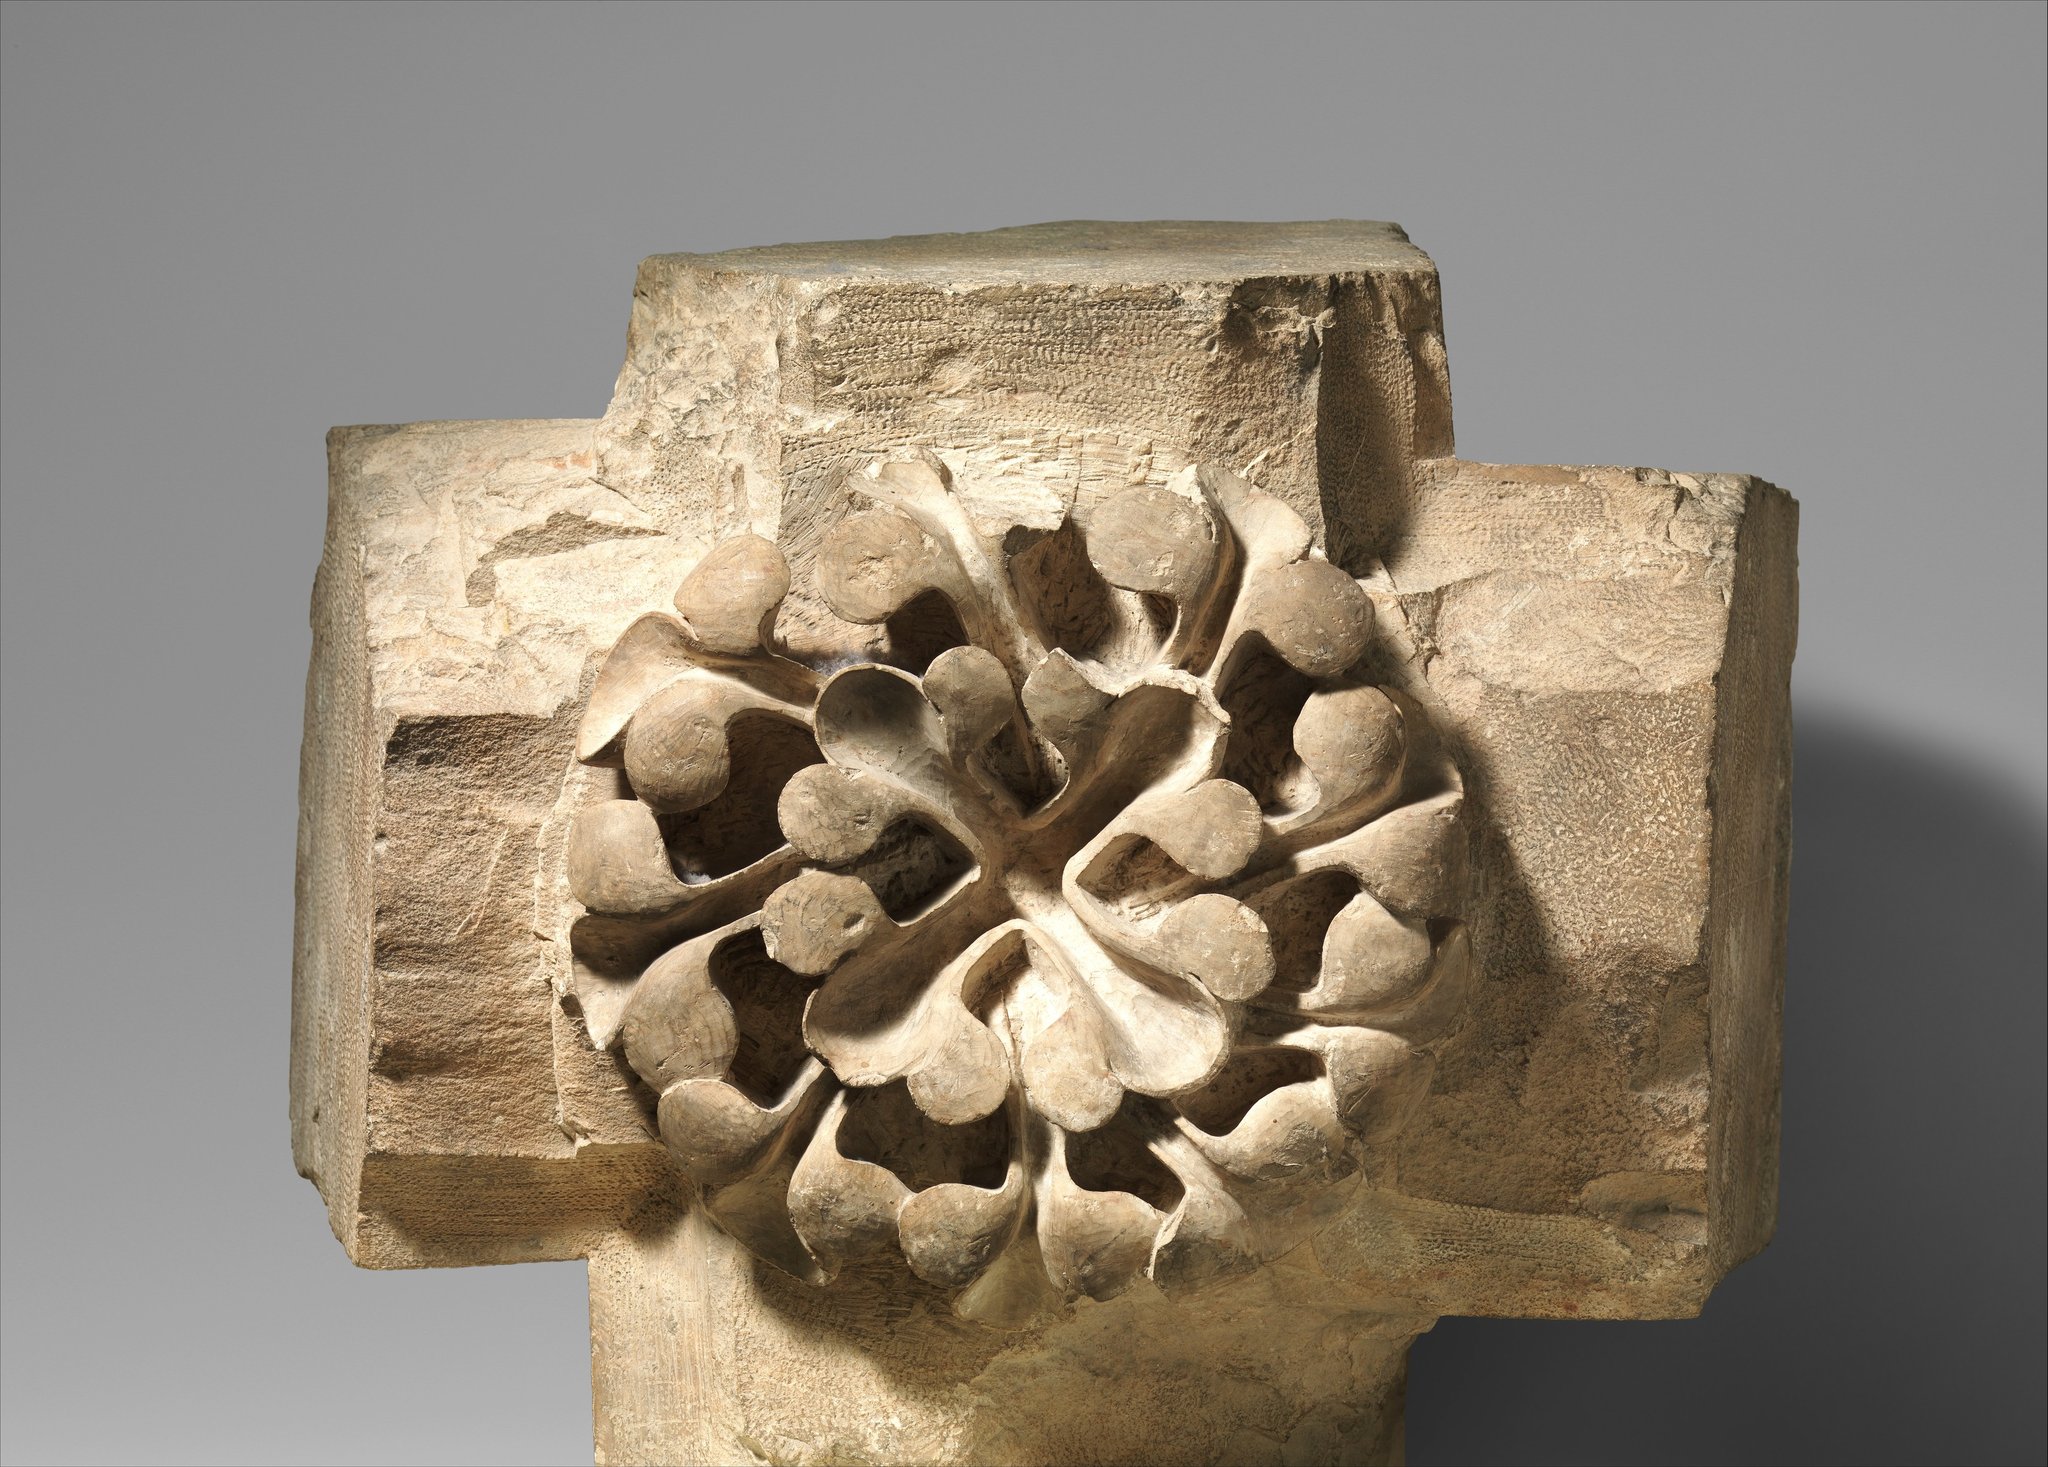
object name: keystone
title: Keystone from a Vaulted Ceiling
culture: german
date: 1220-1230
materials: limestone